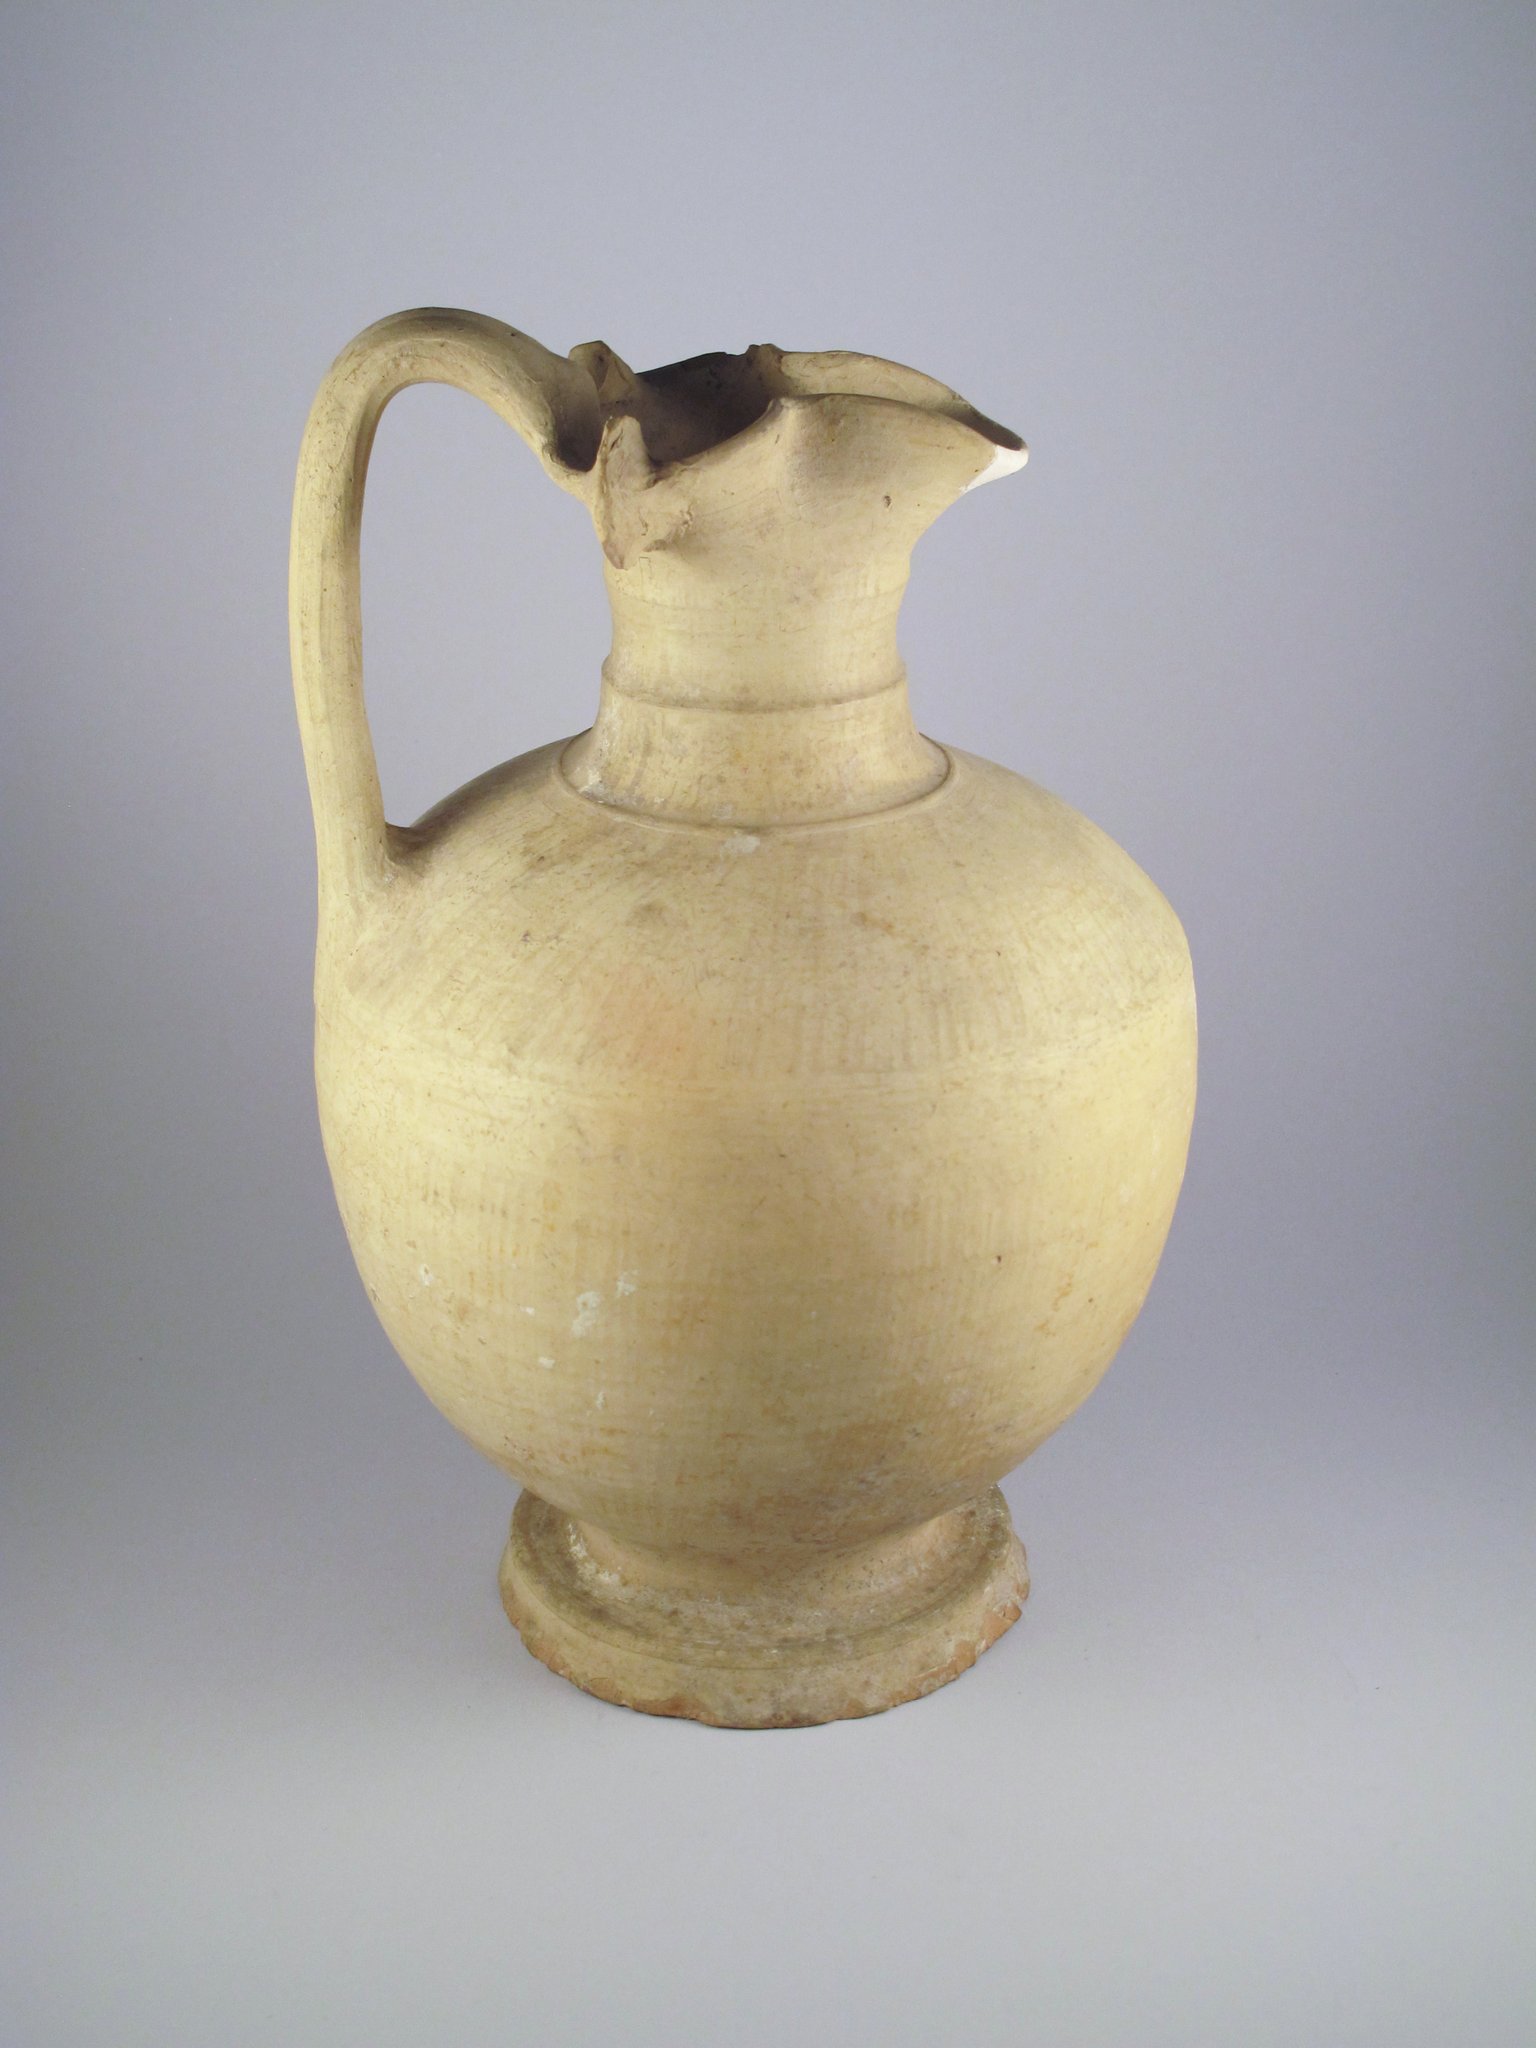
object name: jug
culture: cypriot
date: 480-310 BCE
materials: terracotta